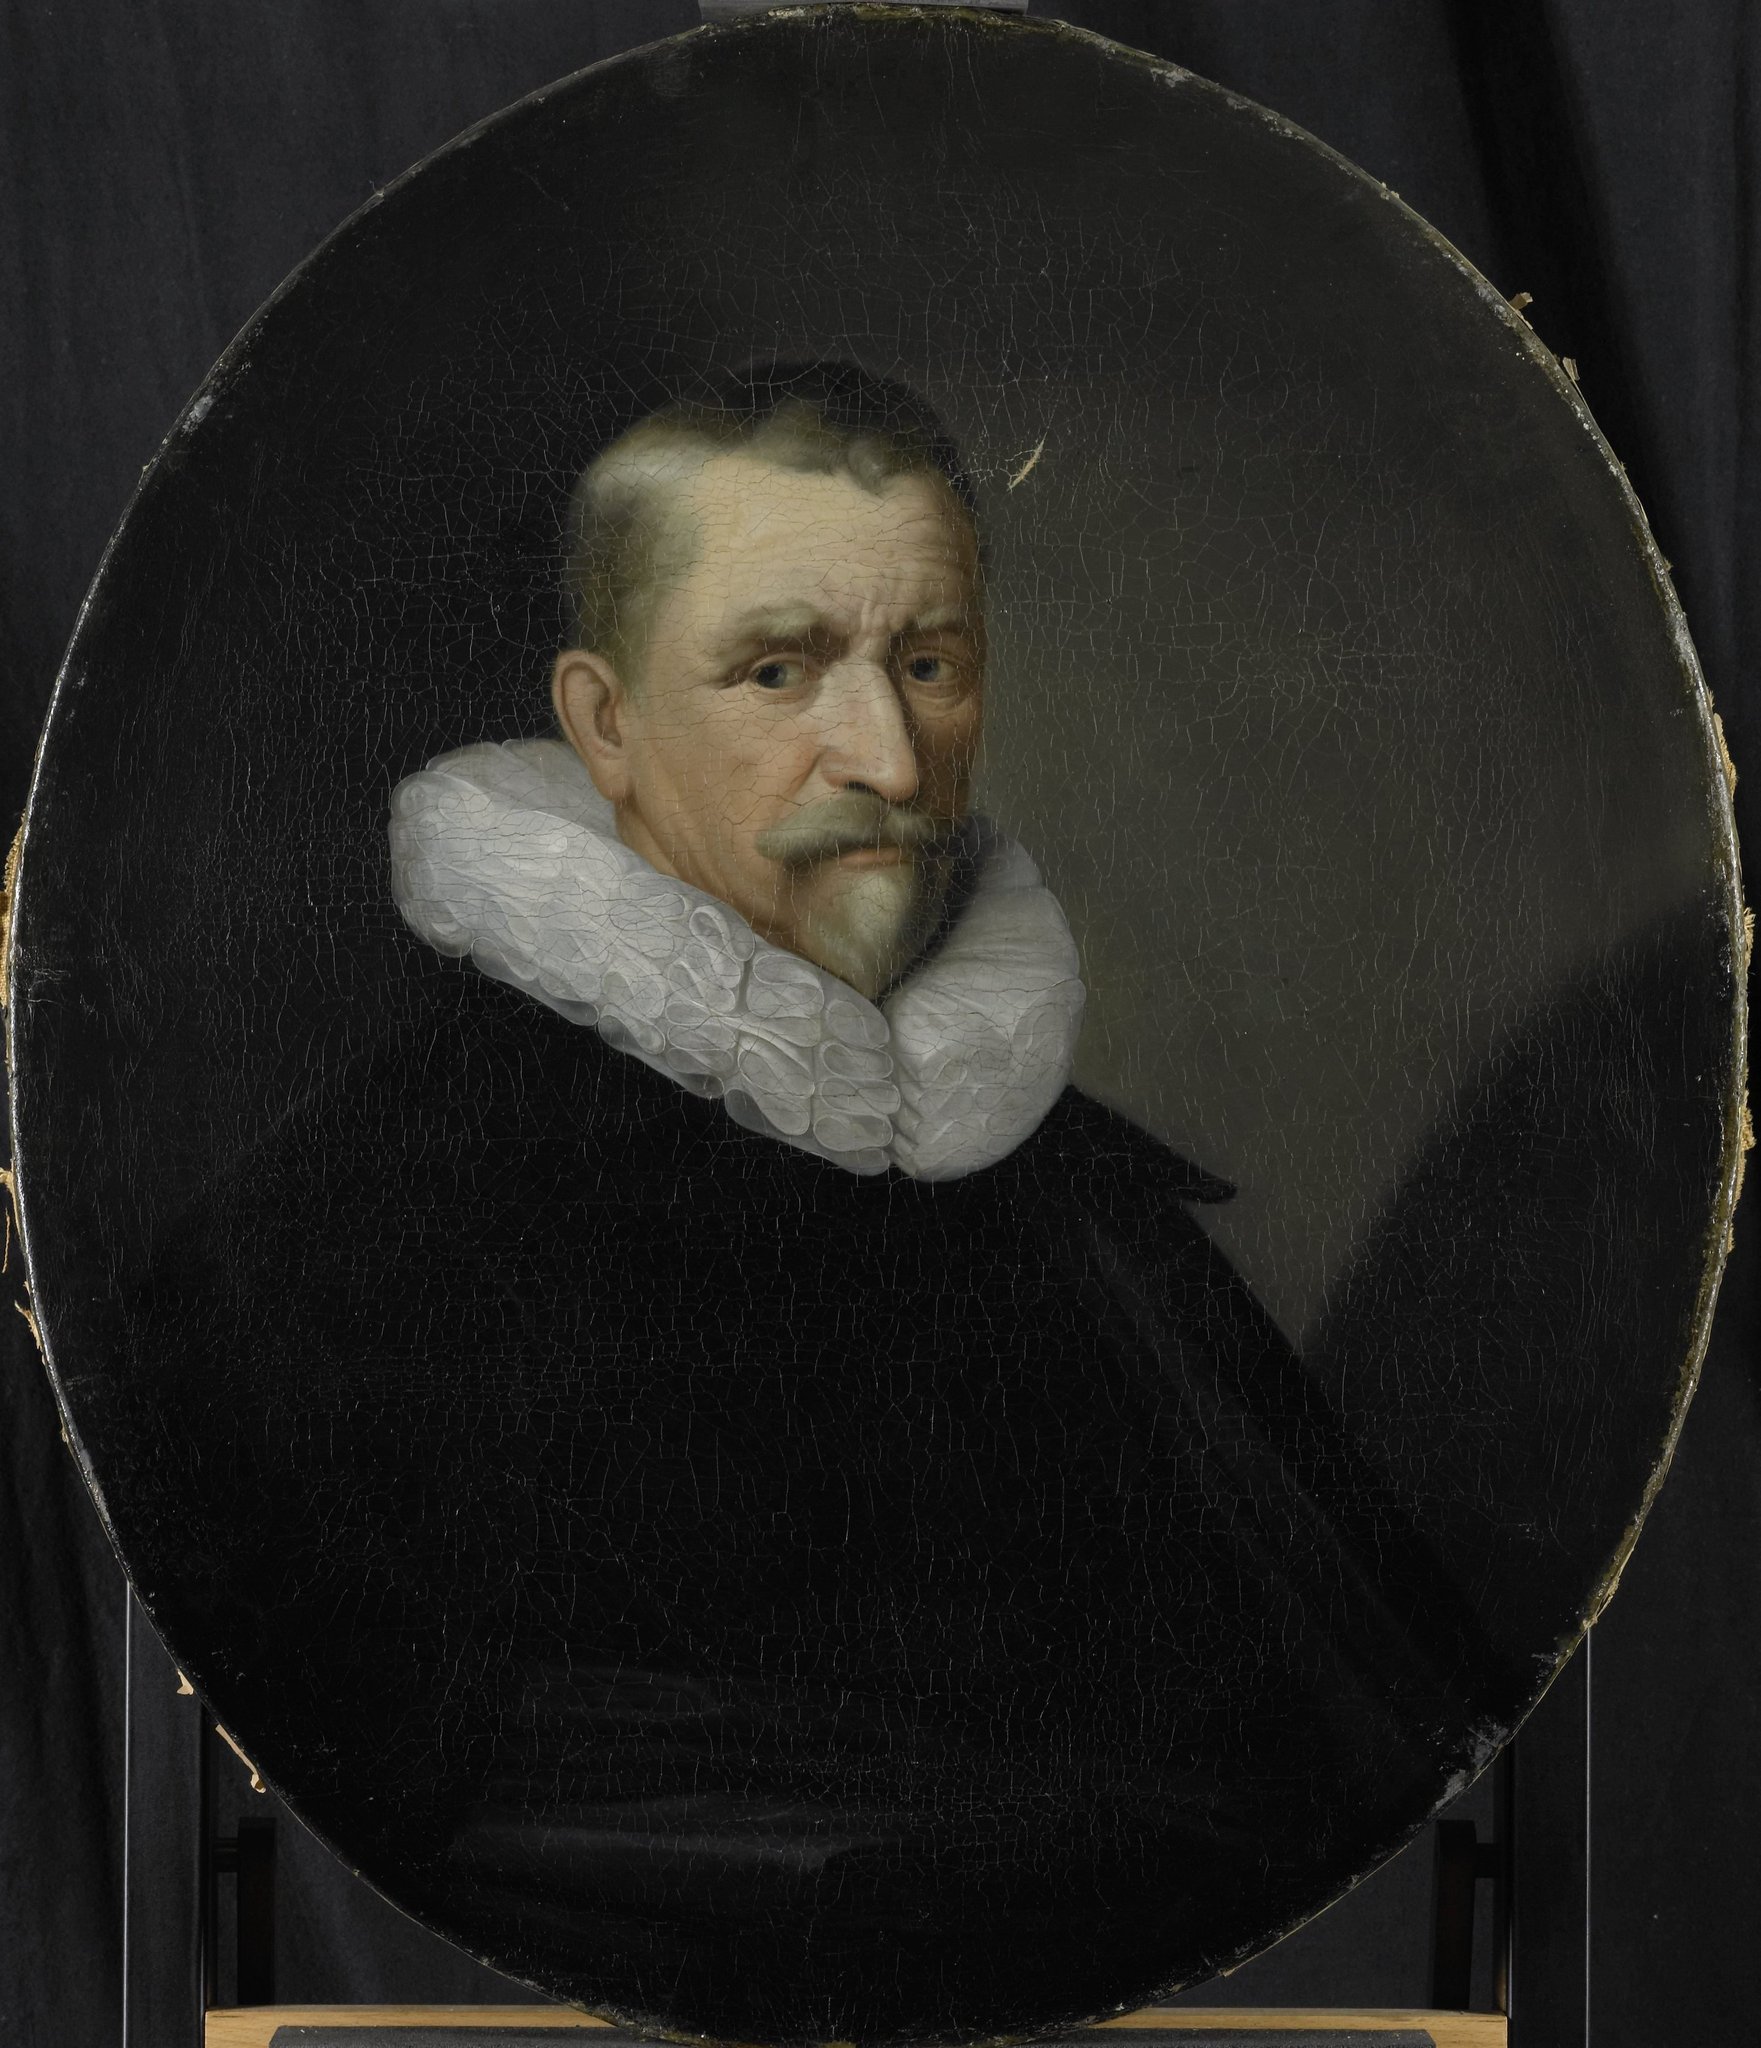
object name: painting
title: Portrait of Cornelis Jansz Hartigsvelt, Director of the Rotterdam Chamber of the Dutch East India Company, elected 1639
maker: pieter van der werff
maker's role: draughtsman, painter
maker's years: 1665-1722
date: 1695-1722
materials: canvas, oil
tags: mayor, rotterdam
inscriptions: inscription: ‘16 Corn. Jansz. Hartigsvelt 39’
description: Portret van Cornelis Jansz Hartigsvelt (voor 1586-1641), gekozen in 1639. Buste in ovaal naar rechts. Onderdeel van een reeks portretten van de bewindhebbers van de Rotterdamse Kamer van de Verenigde Oost-Indische Compagnie, vervaardigd voor het Nieuw Oost-Indisch Huis uit 1698 aan de Boompjes te Rotterdam.